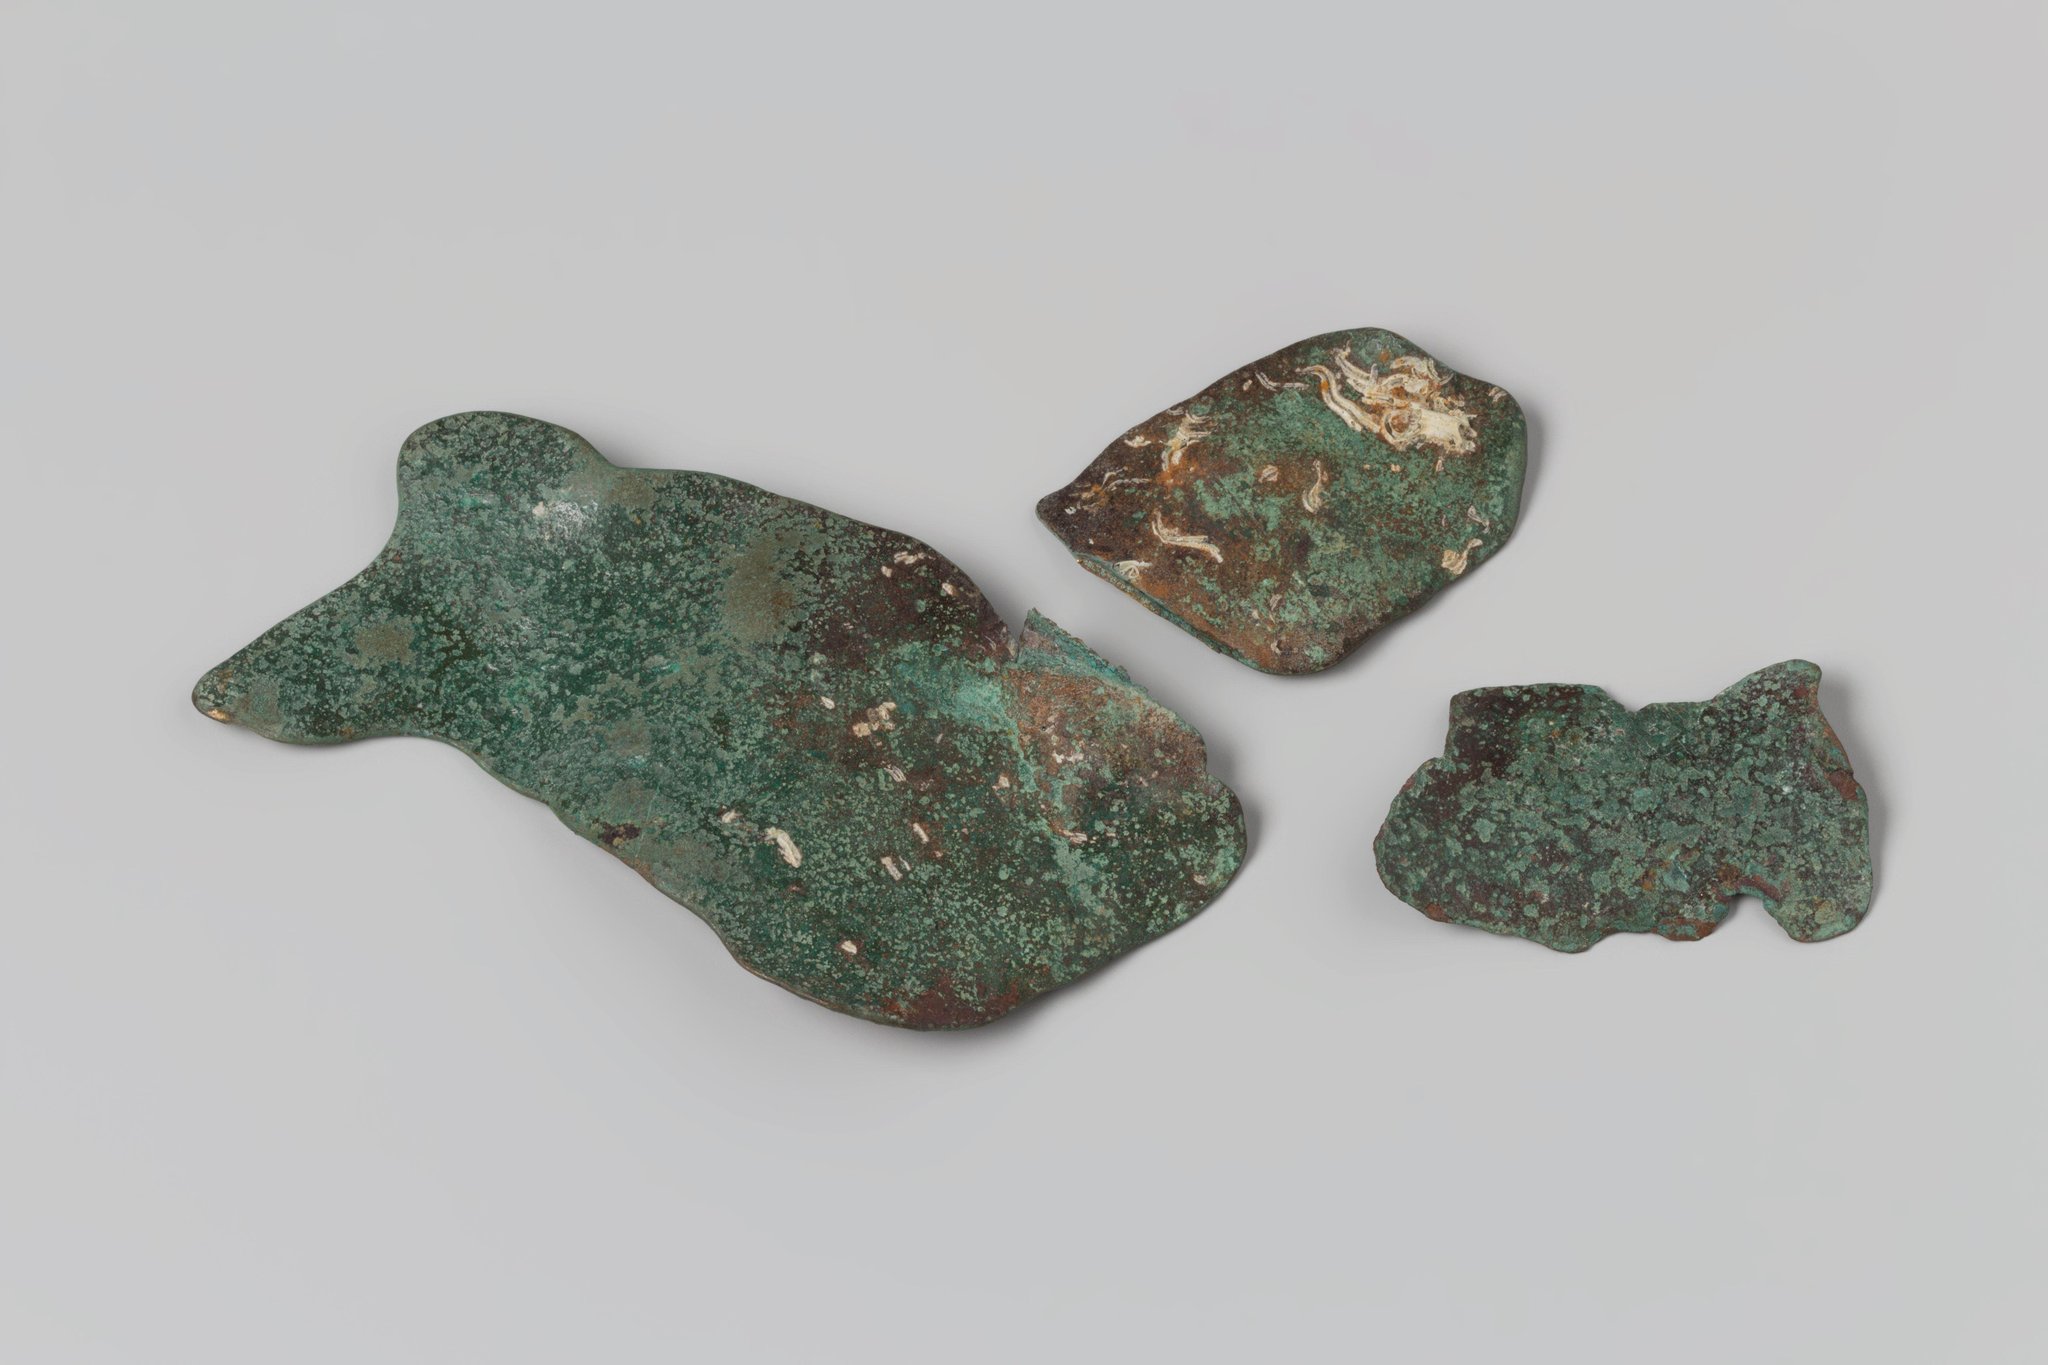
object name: scheepswrakvondst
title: Fragmenten van koper uit het wrak van de Oost-Indiëvaarder Hollandia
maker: Anonymous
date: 1700-1743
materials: copper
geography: netherlands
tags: verenigde oostindische compagnie, hollandia (schip), annet